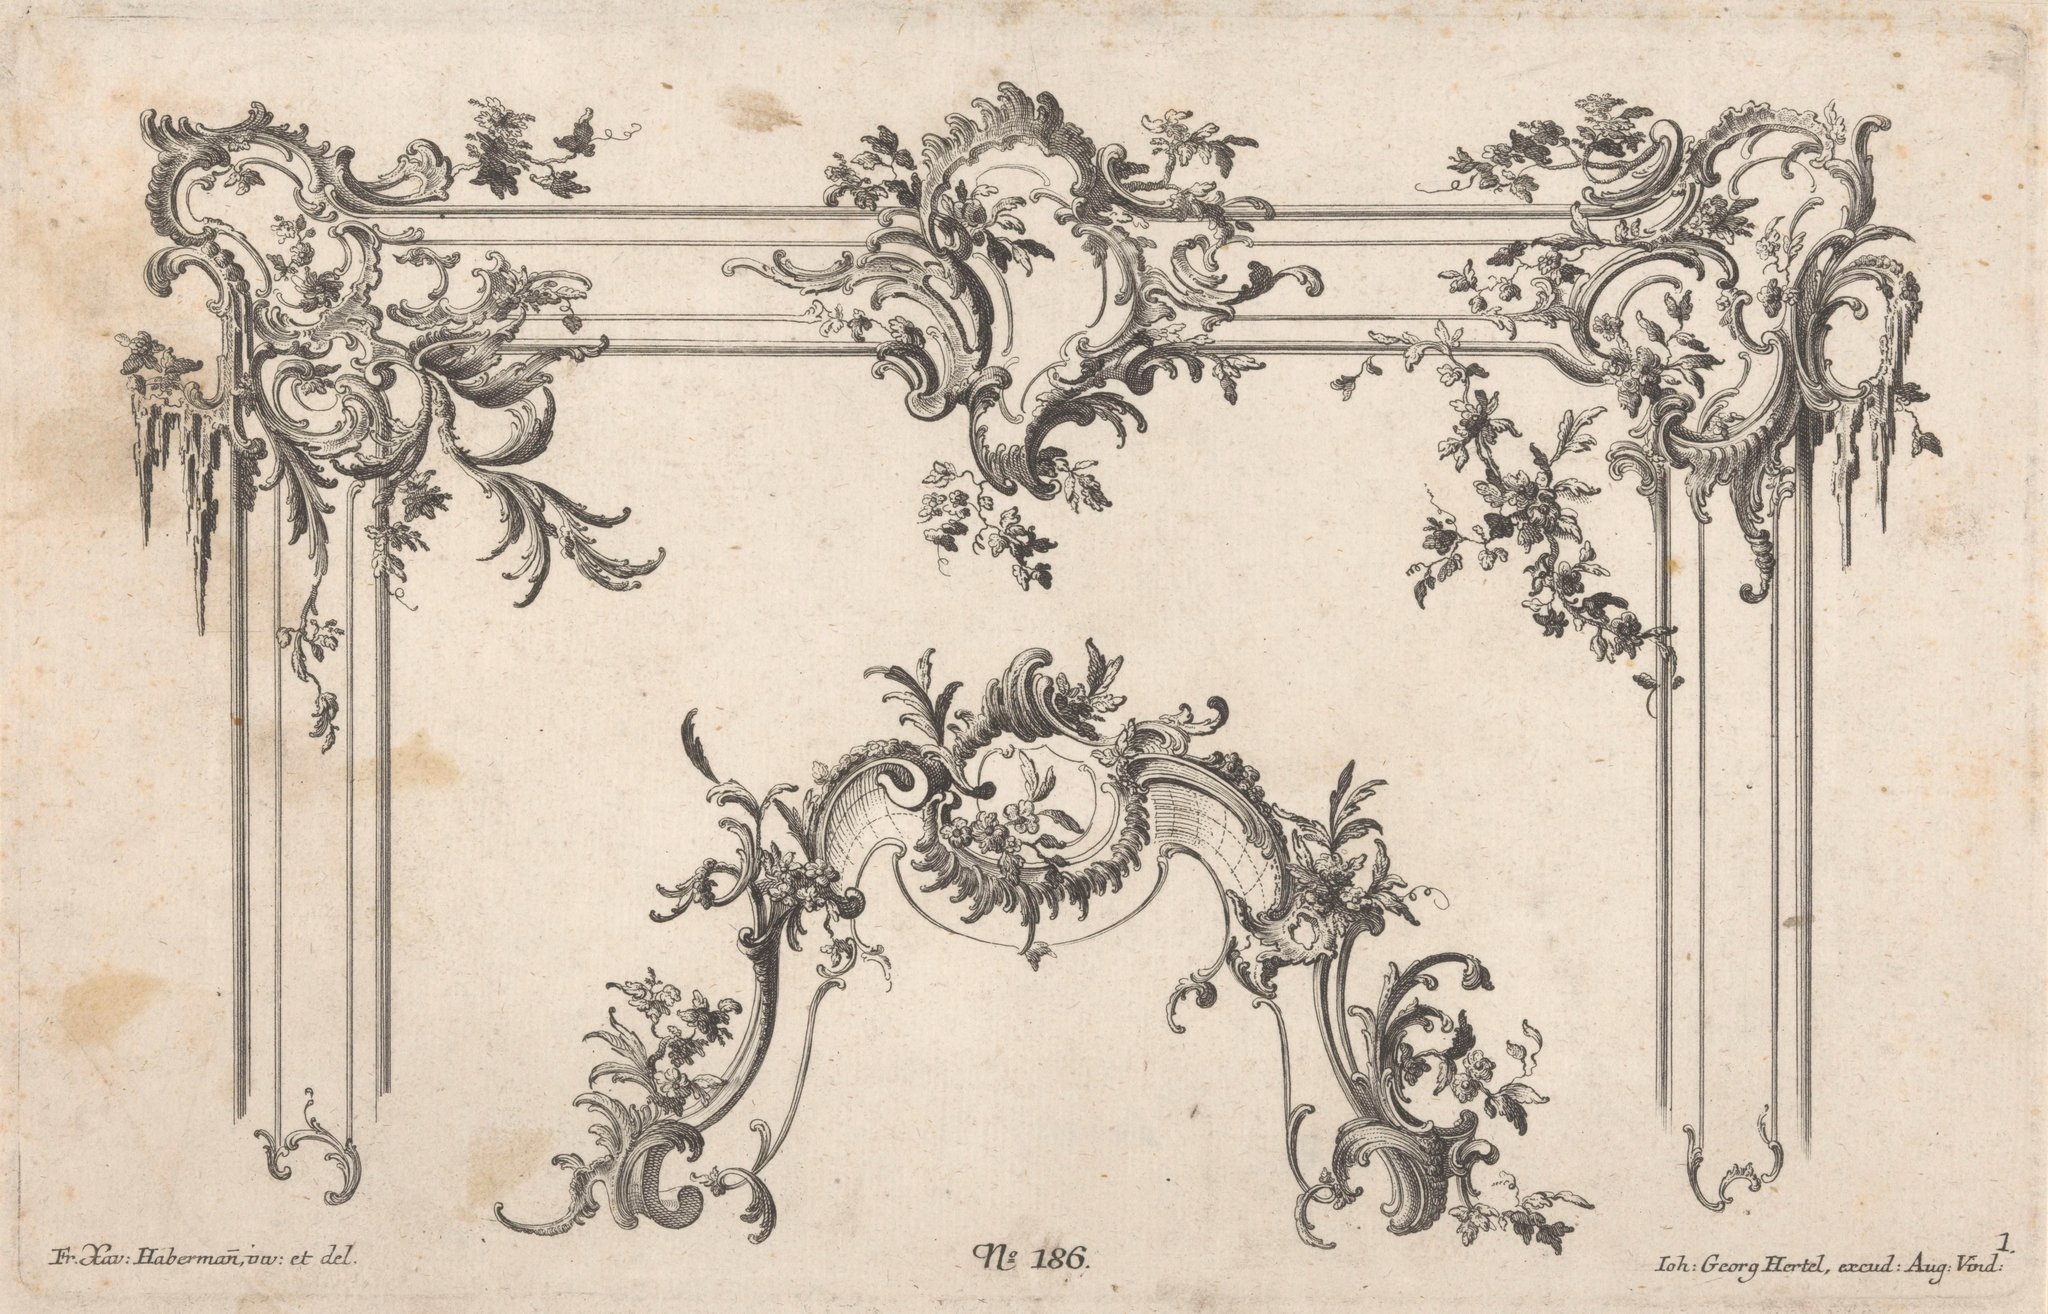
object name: print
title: Omlijstingen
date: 1731-1775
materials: paper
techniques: etching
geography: augsburg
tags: rocaille ornament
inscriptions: collector's mark: Lugt 2760, collector's mark: Lugt 2228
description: Twee omlijstingen met rocaille ornamenten en bloemmotieven. Uitgeversnummer 186.